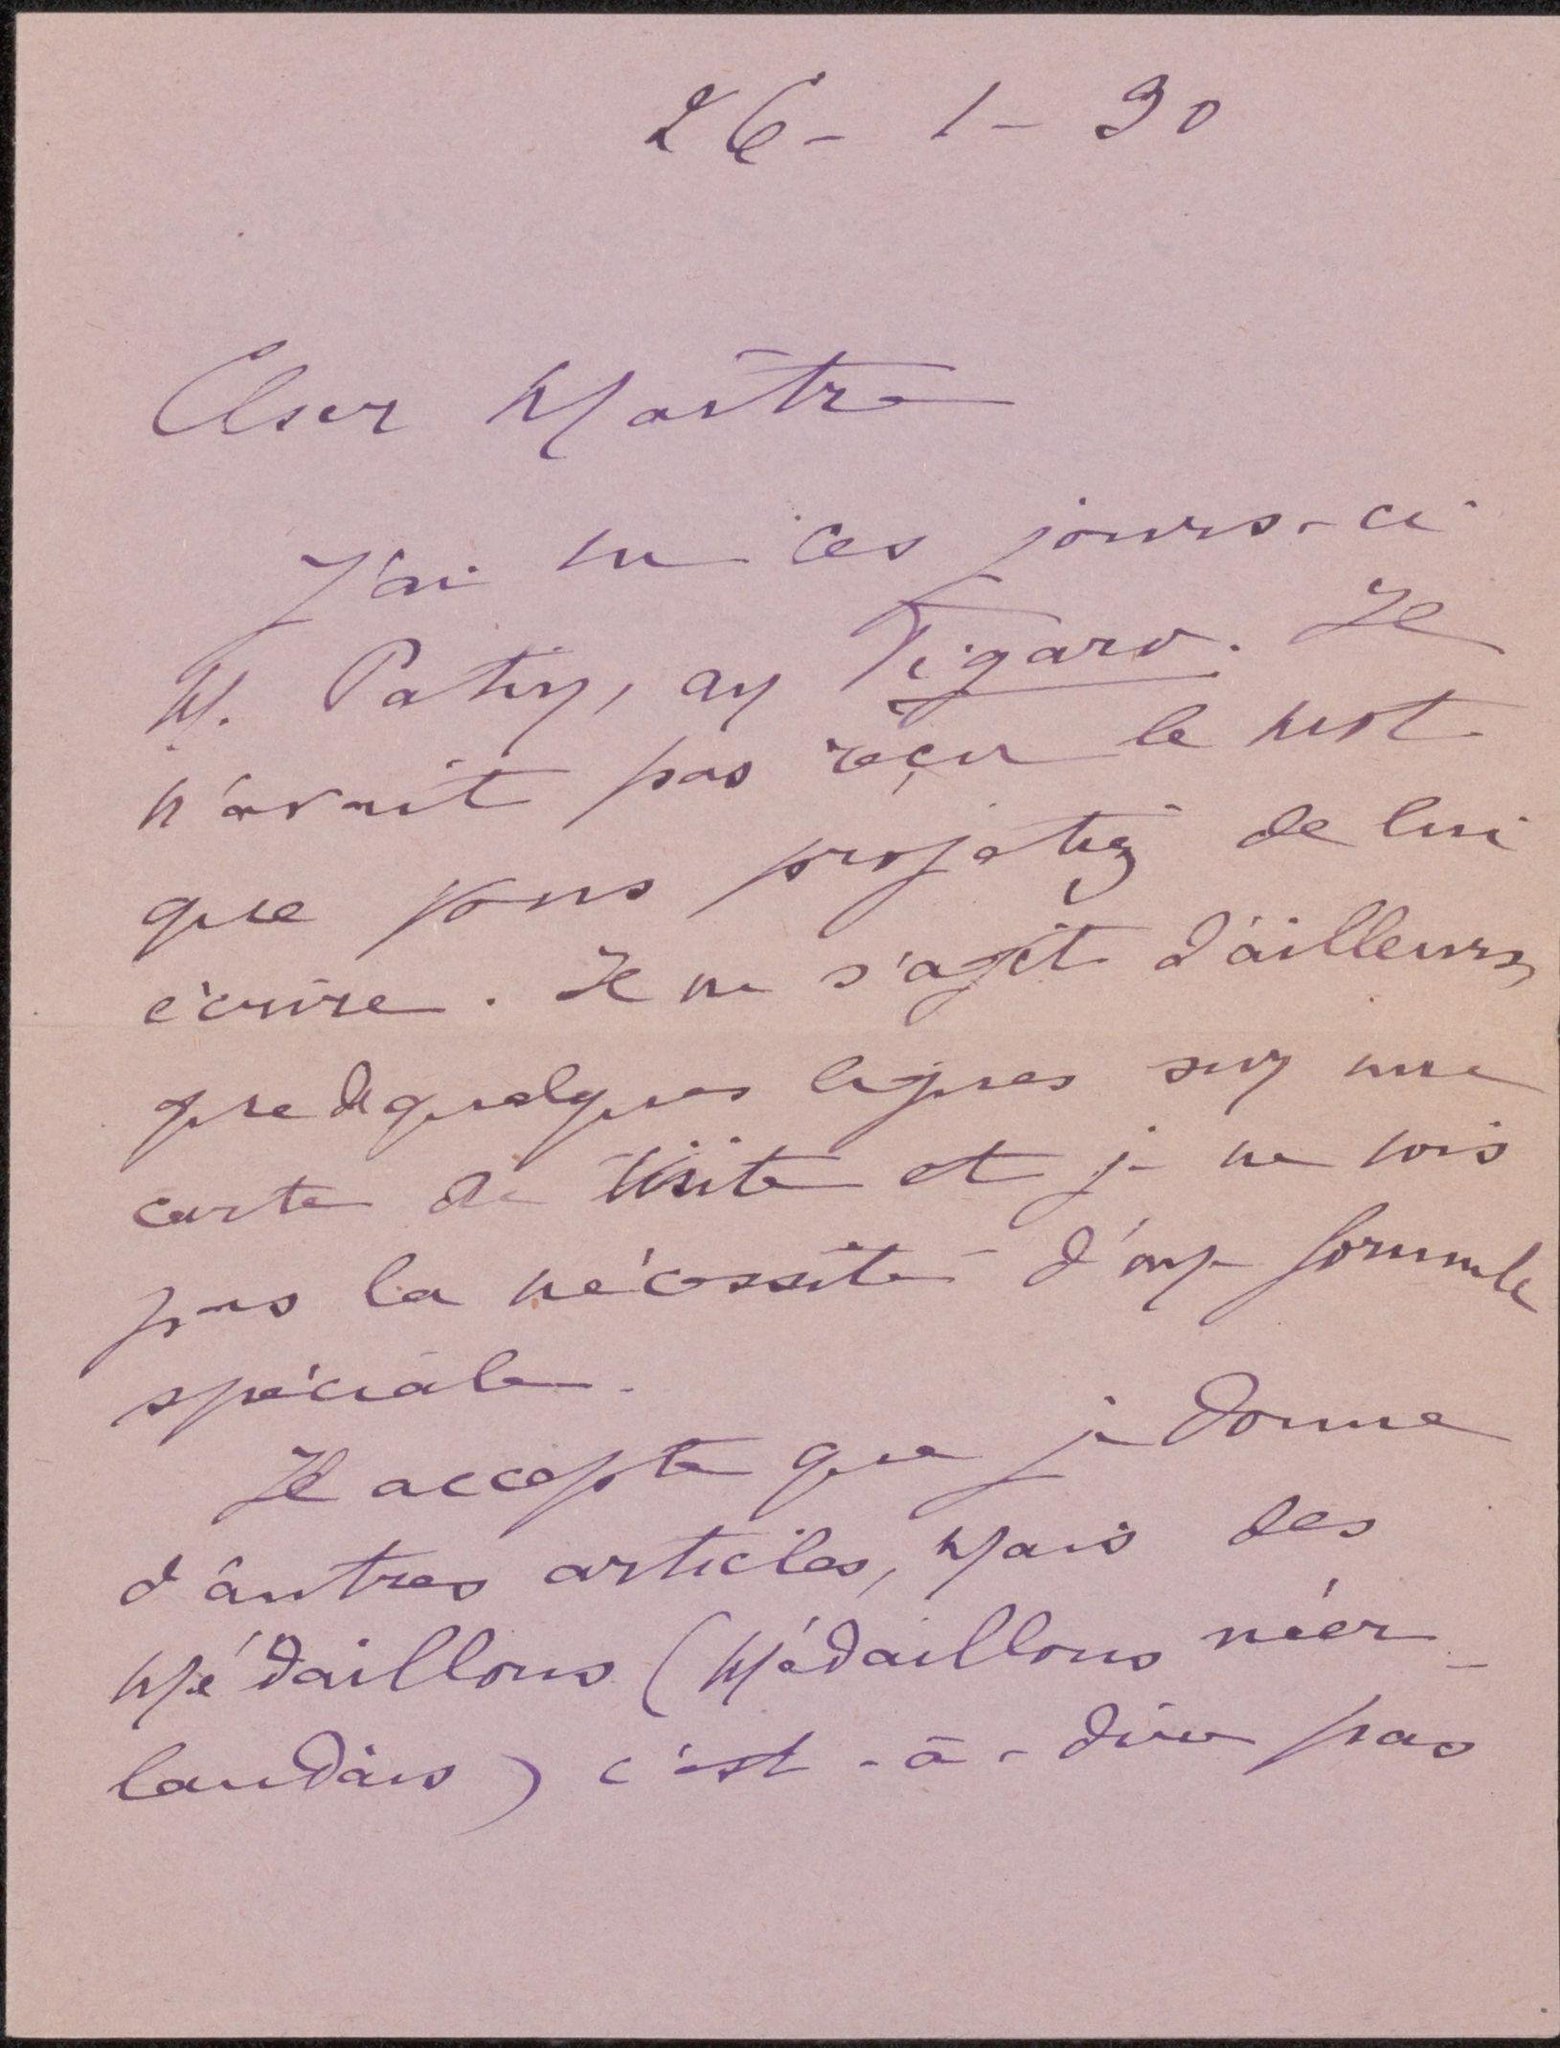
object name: letter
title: Brief aan Philip Zilcken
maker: lya berger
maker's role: schrijver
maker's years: 1877-1941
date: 1930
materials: ink, paper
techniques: pen, writing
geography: paris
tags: maria biermé, the hague, painter, draughtsman, philip zilcken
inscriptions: collector's mark: ‘RPK’, address: ‘Mlle. L. Berger/ 2, Square du Croisic, XVe’